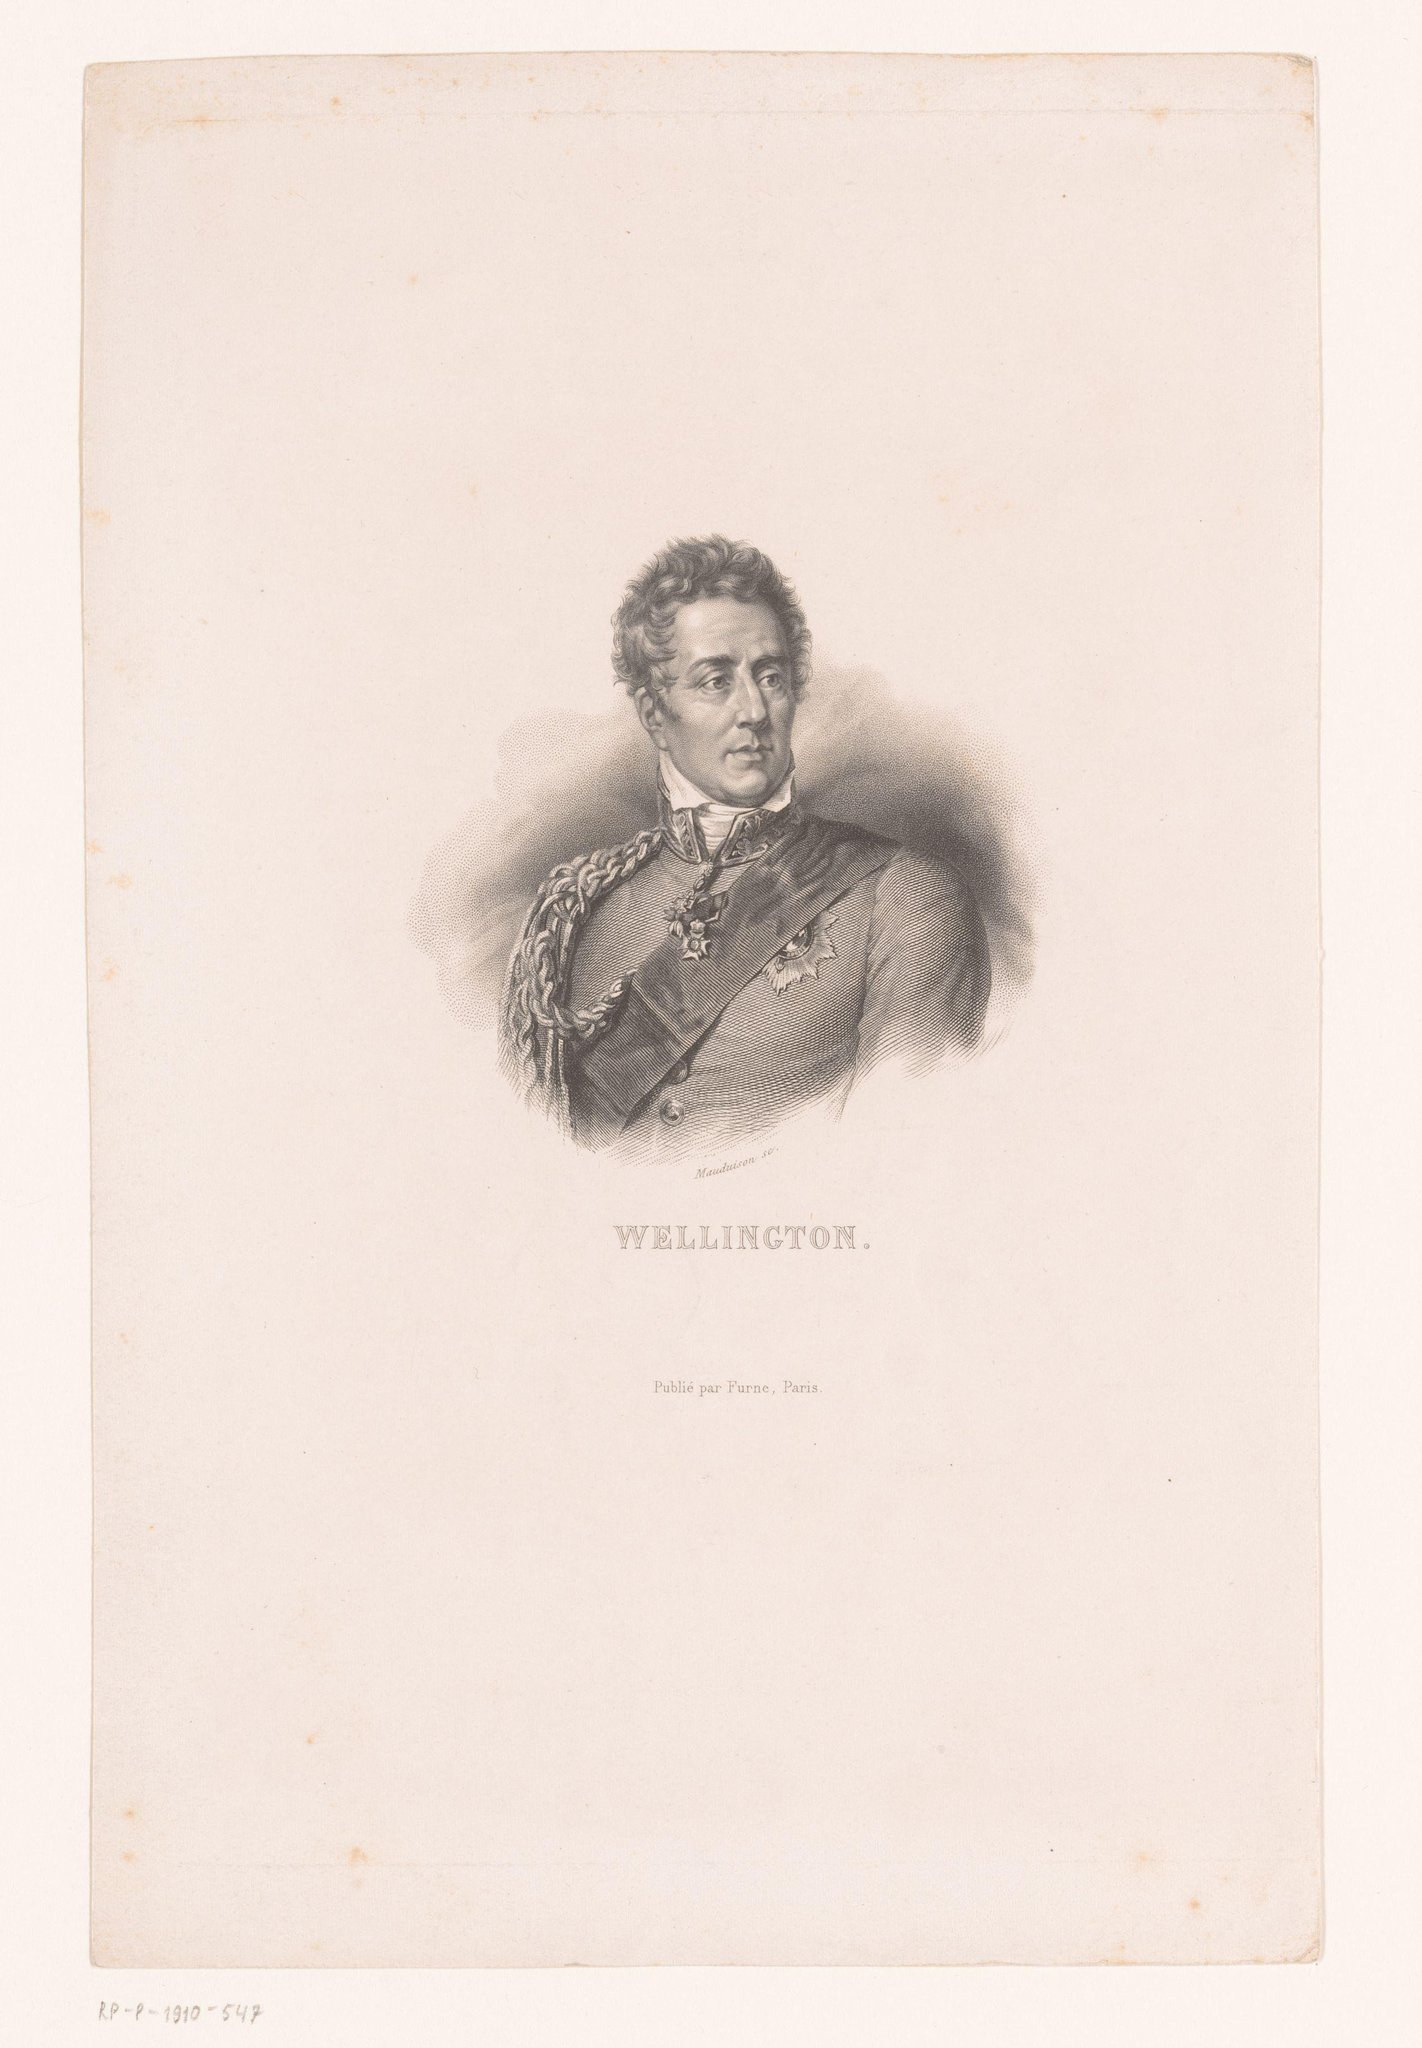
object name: print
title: Wellington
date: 1848-1886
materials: paper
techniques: engraving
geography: paris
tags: walmer castle, arthur wellesley of wellington, historical persons, nobility and patriciate; chivalry, knighthood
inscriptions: collector's mark: Lugt 2228